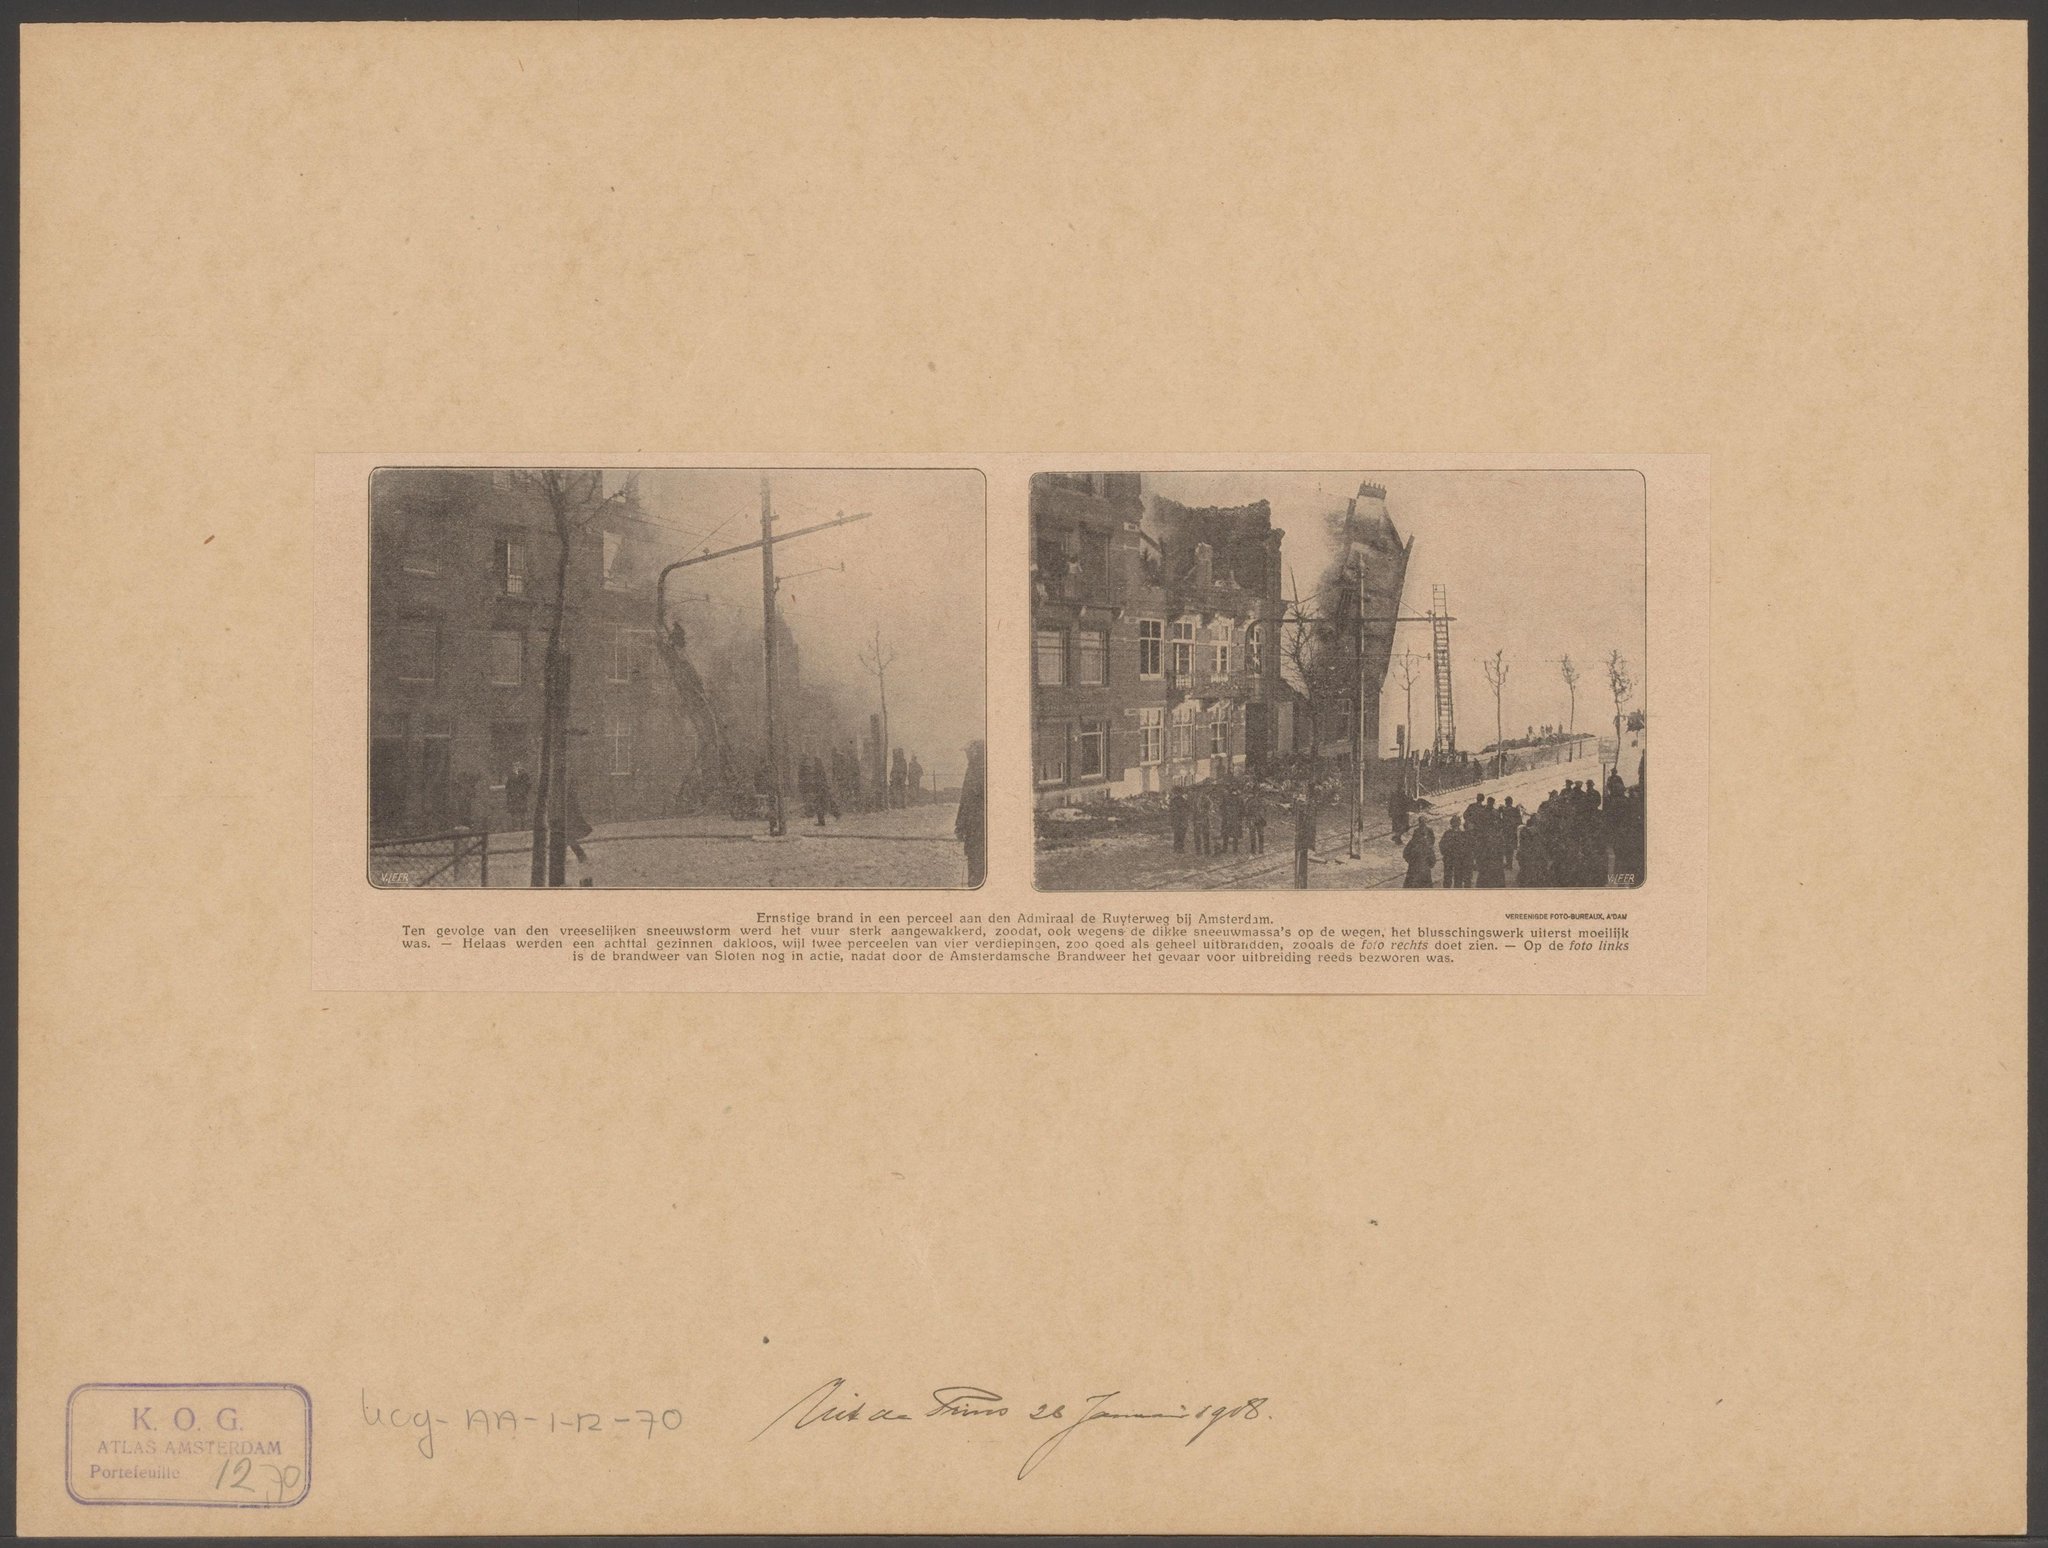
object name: photomechanical print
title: Gezicht op twee in brand staande panden aan de Admiraal de Ruijterweg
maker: nicolaas jan boon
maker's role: publisher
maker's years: 1862-1921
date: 1918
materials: paper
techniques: letterpress printing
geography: amsterdam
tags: on fire, ablaze, city-view in general; 'veduta', fire-fighting, the usual house or row of houses, street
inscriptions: collector's mark: ‘12,70’ Lugt 1641b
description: Onderwerpsrubriek binnen de Atlas Amsterdam: Rokin, Rotterdammersloot, Rozengang, Rozengracht, Rozenstraat, Rusland, Rustenburgerstraat, Ruysdaelkade, Ruysdaelstraat, Ruyterkade (de), Ruyterweg (Admiraal de).